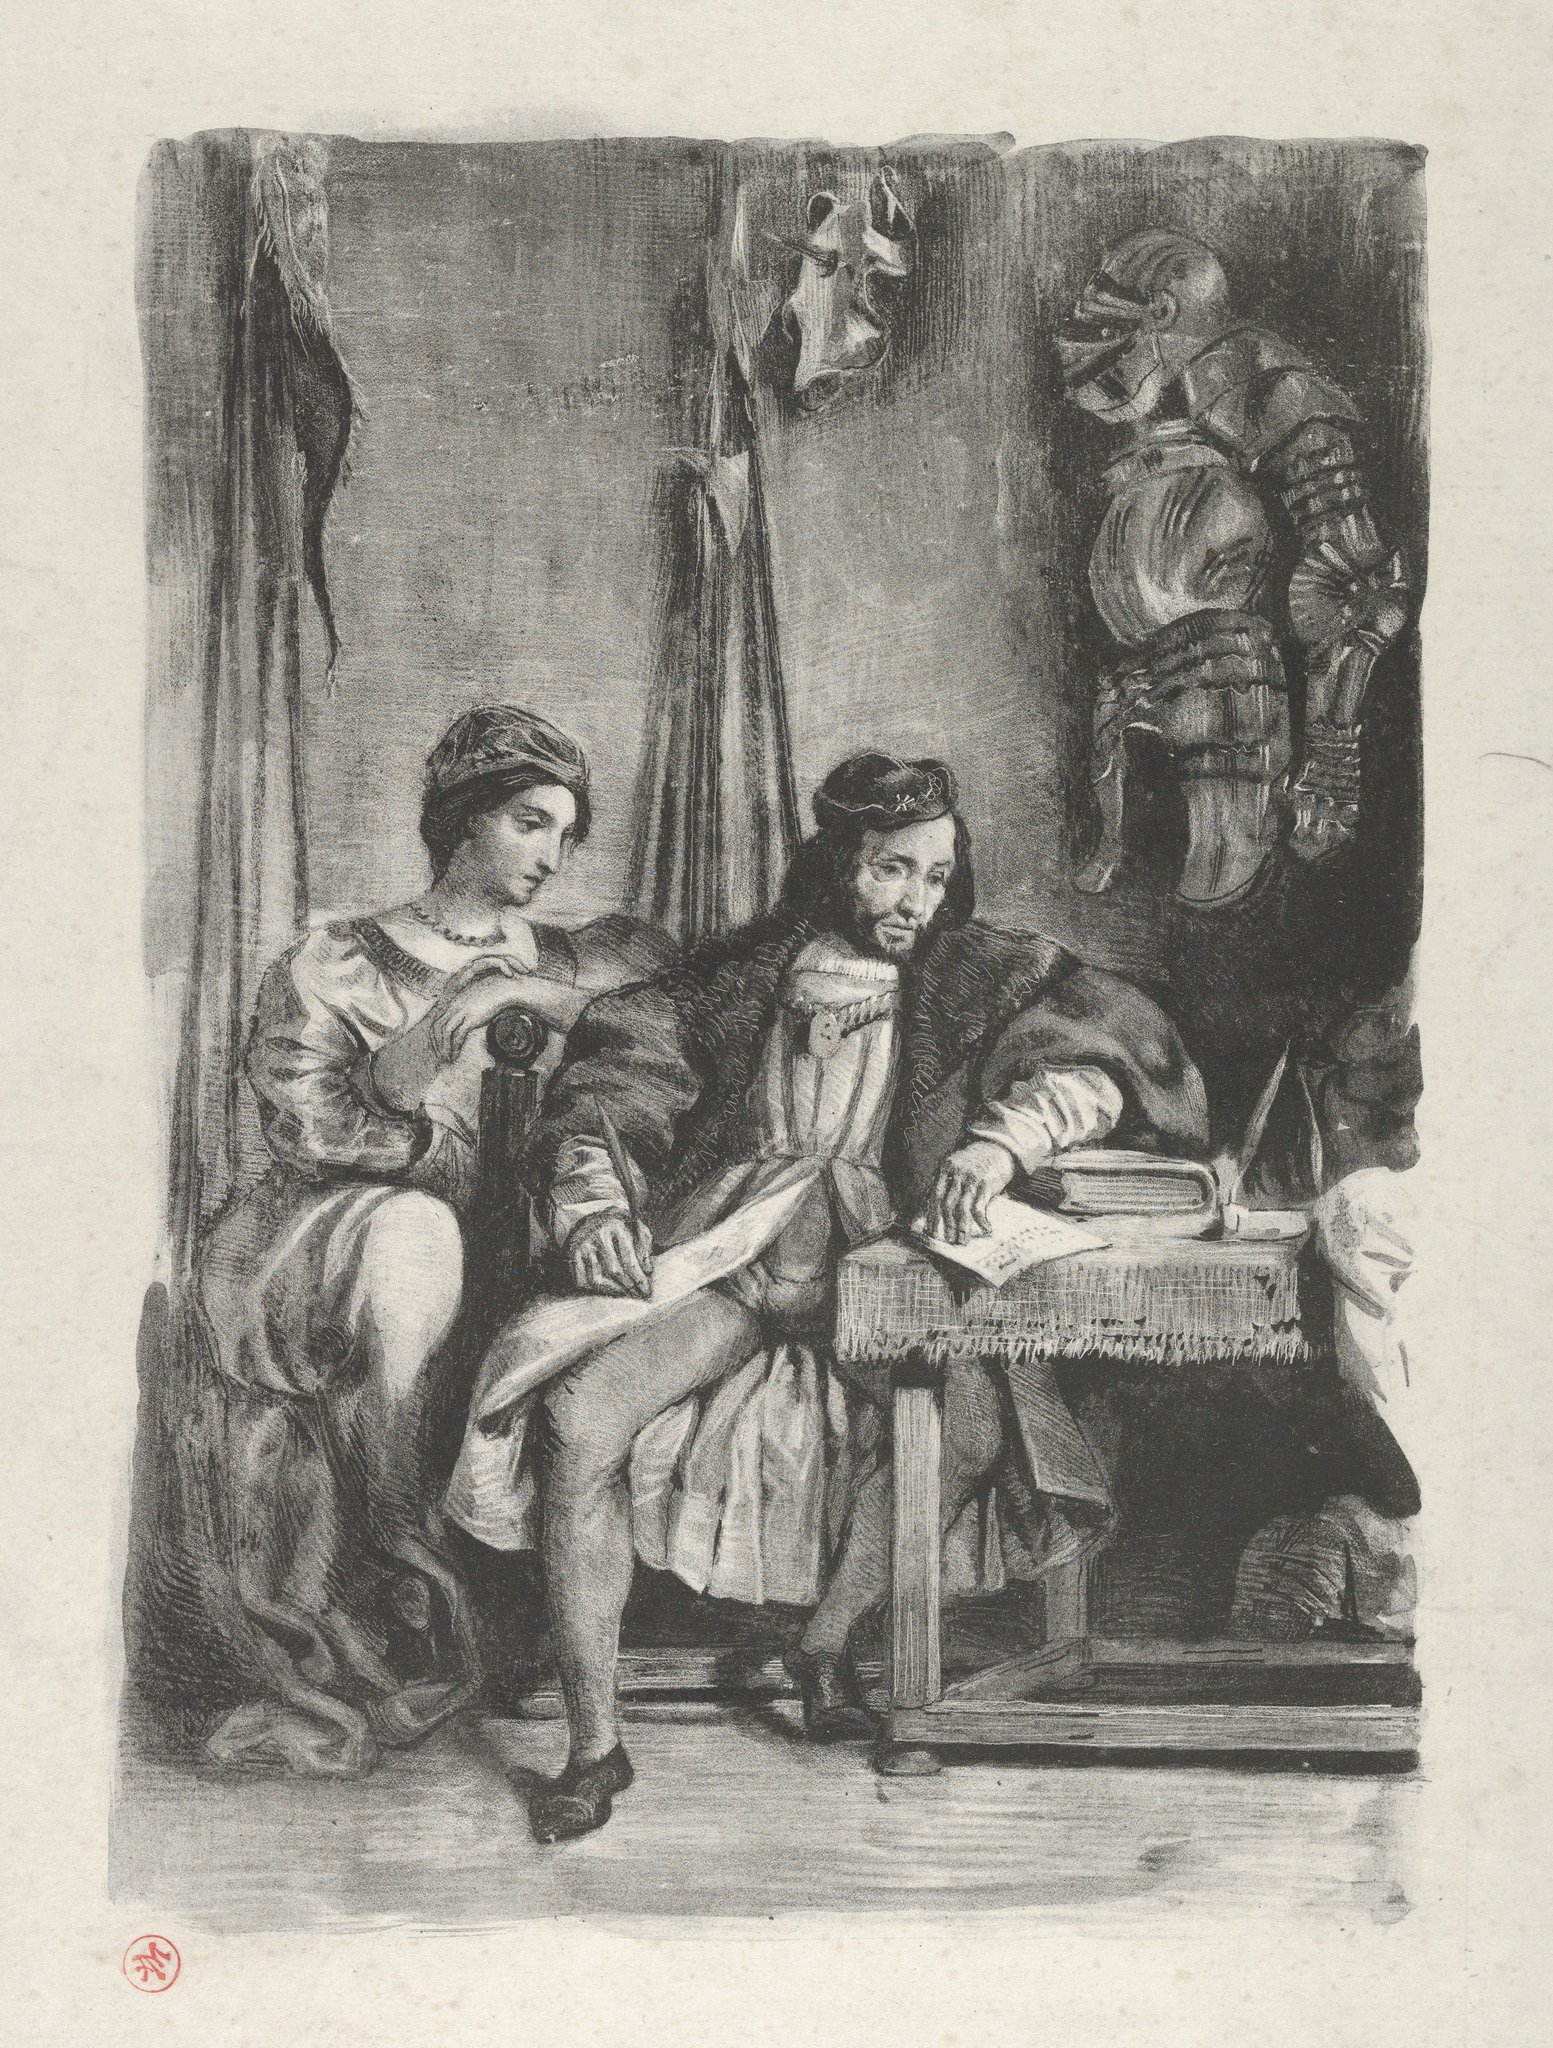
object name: print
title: Goetz von Berlichingen Writing his Memoirs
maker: eugène delacroix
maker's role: artist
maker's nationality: french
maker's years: 1798-1863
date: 1836-1843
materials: paper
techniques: lithograph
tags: armor,men,women,writing